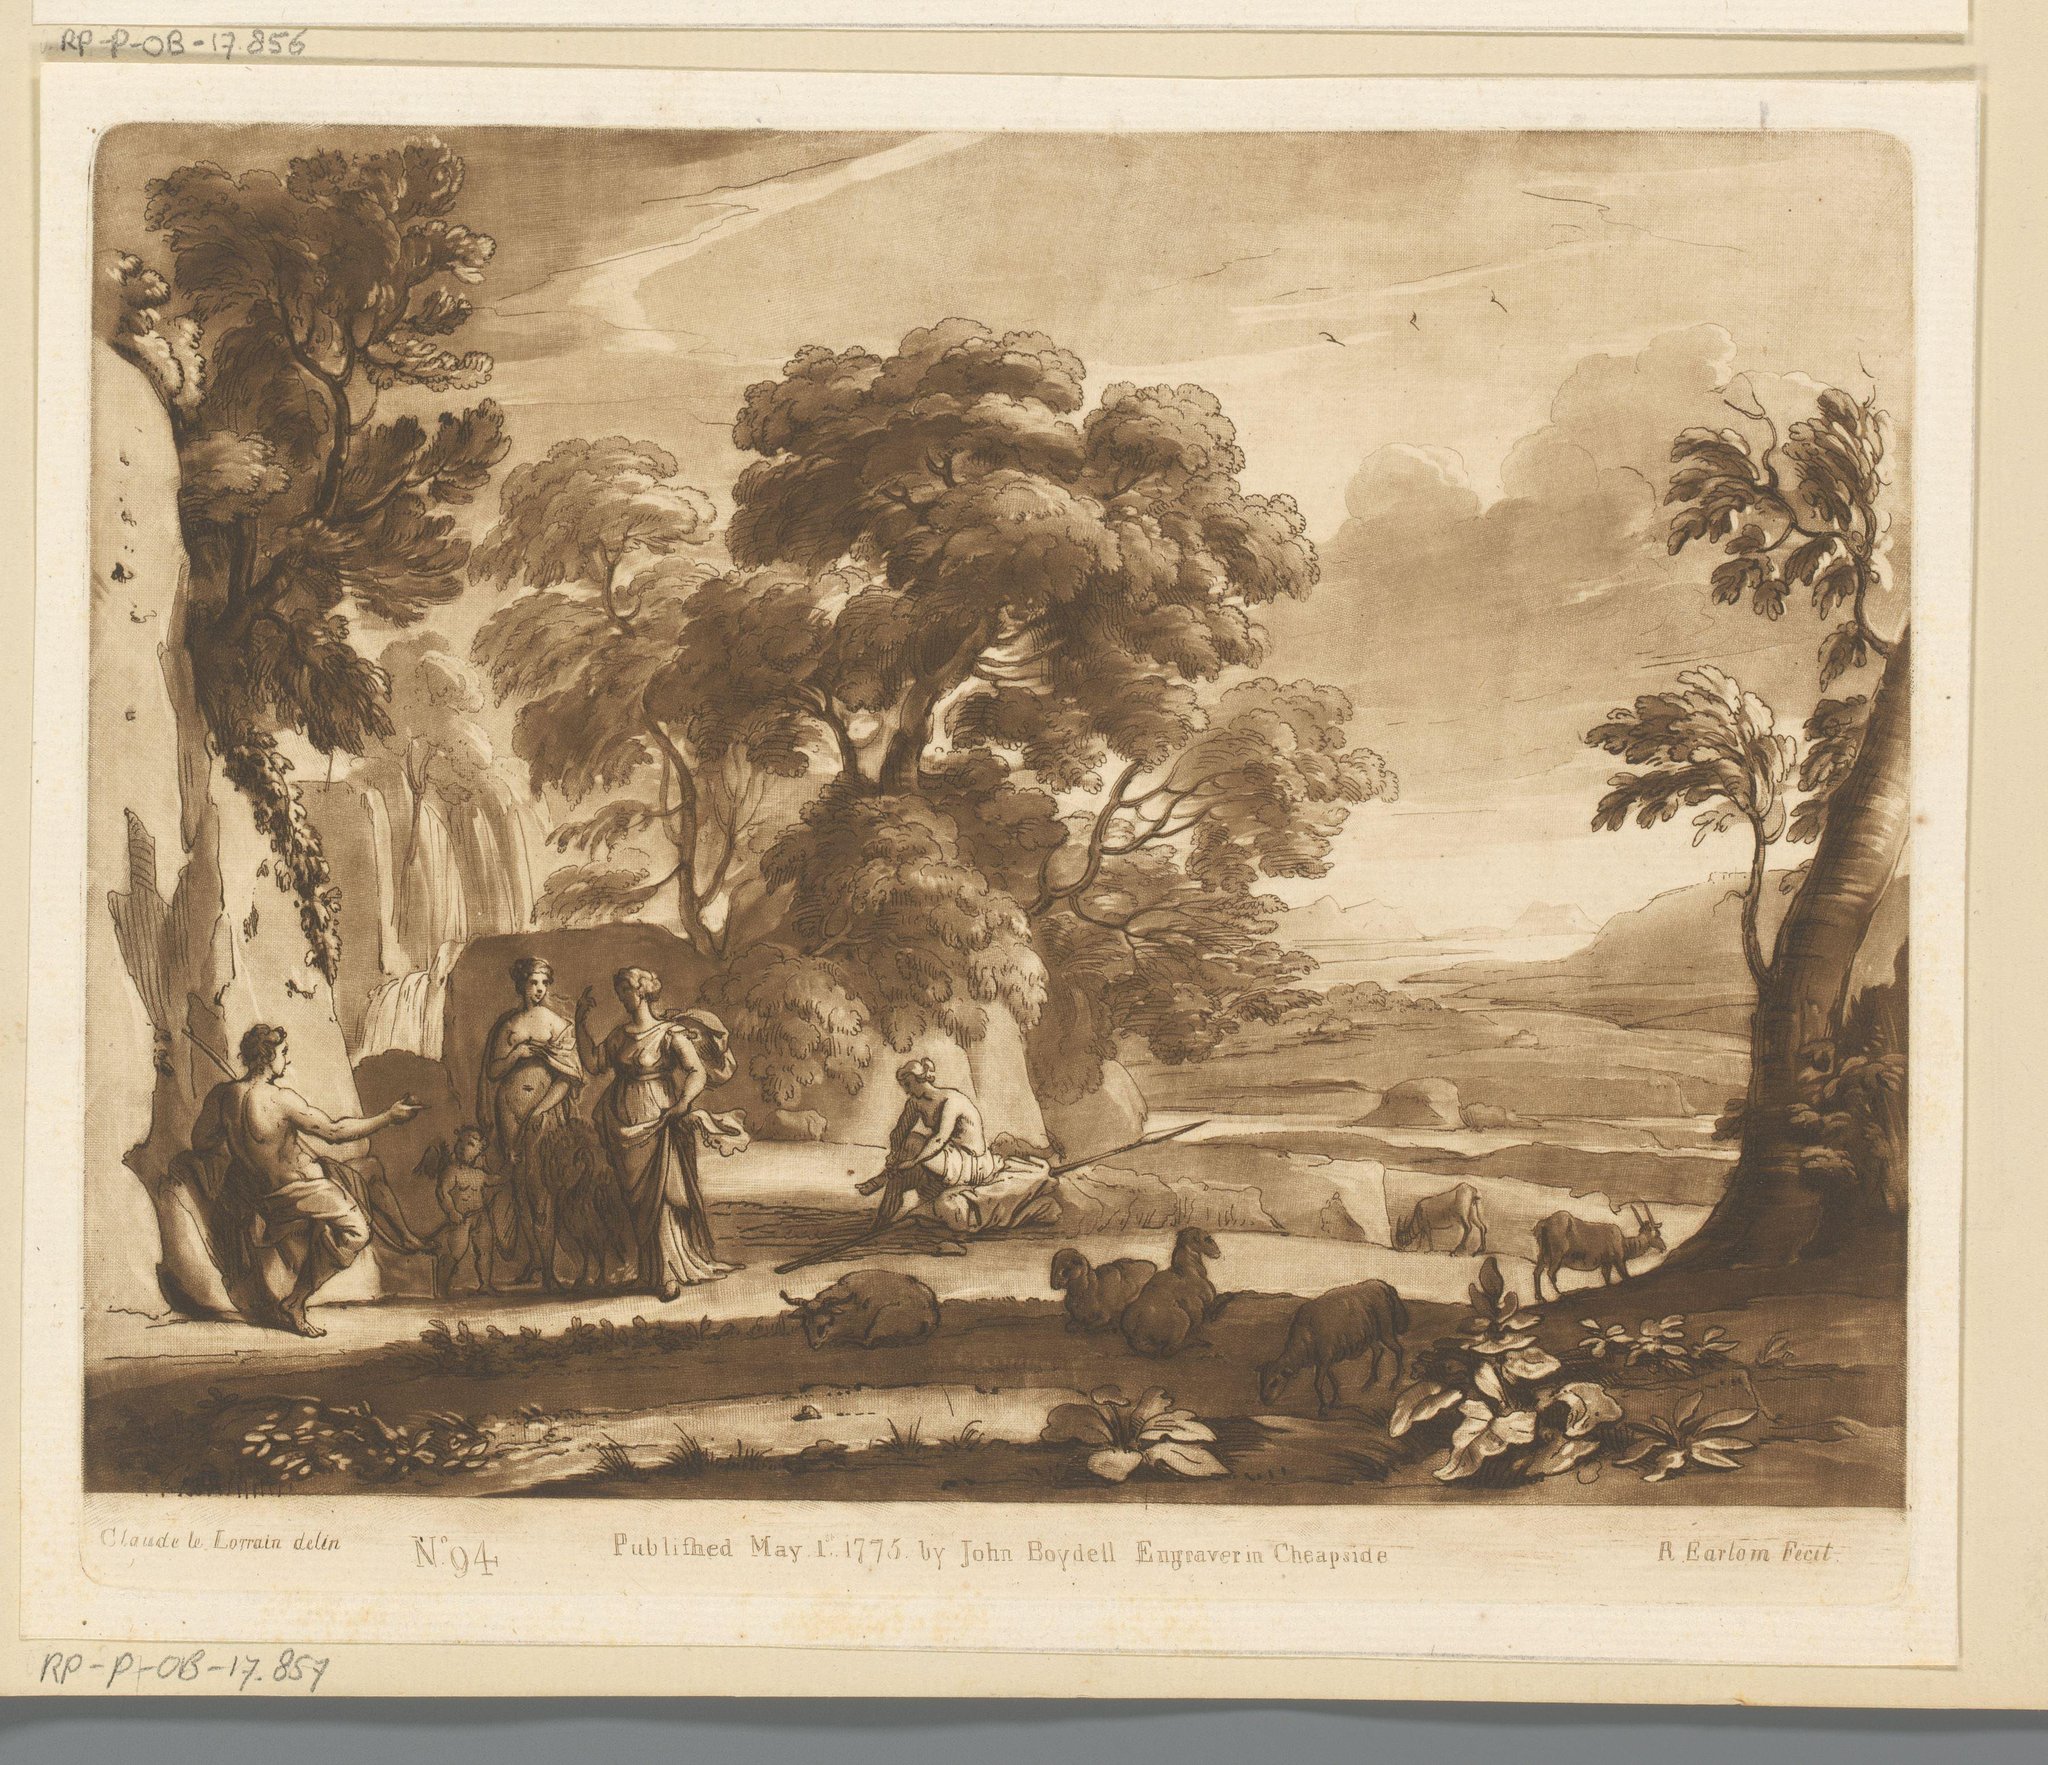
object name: print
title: Prenten naar tekeningen van Claude Lorrain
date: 1775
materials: paper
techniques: etching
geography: london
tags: dale, valley - hh - ideal landscapes, the judgement of paris (without mercury)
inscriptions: date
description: Vanaf 1774 publiceerde John Boydell tweehonderd prenten naar het tekeningenboek Liber Veritatis van Claude Lorrain, in het bezit van de hertogen van Cavendish. Deze prenten werden vanaf 1777 in twee volumes gebundeld uitgegeven.